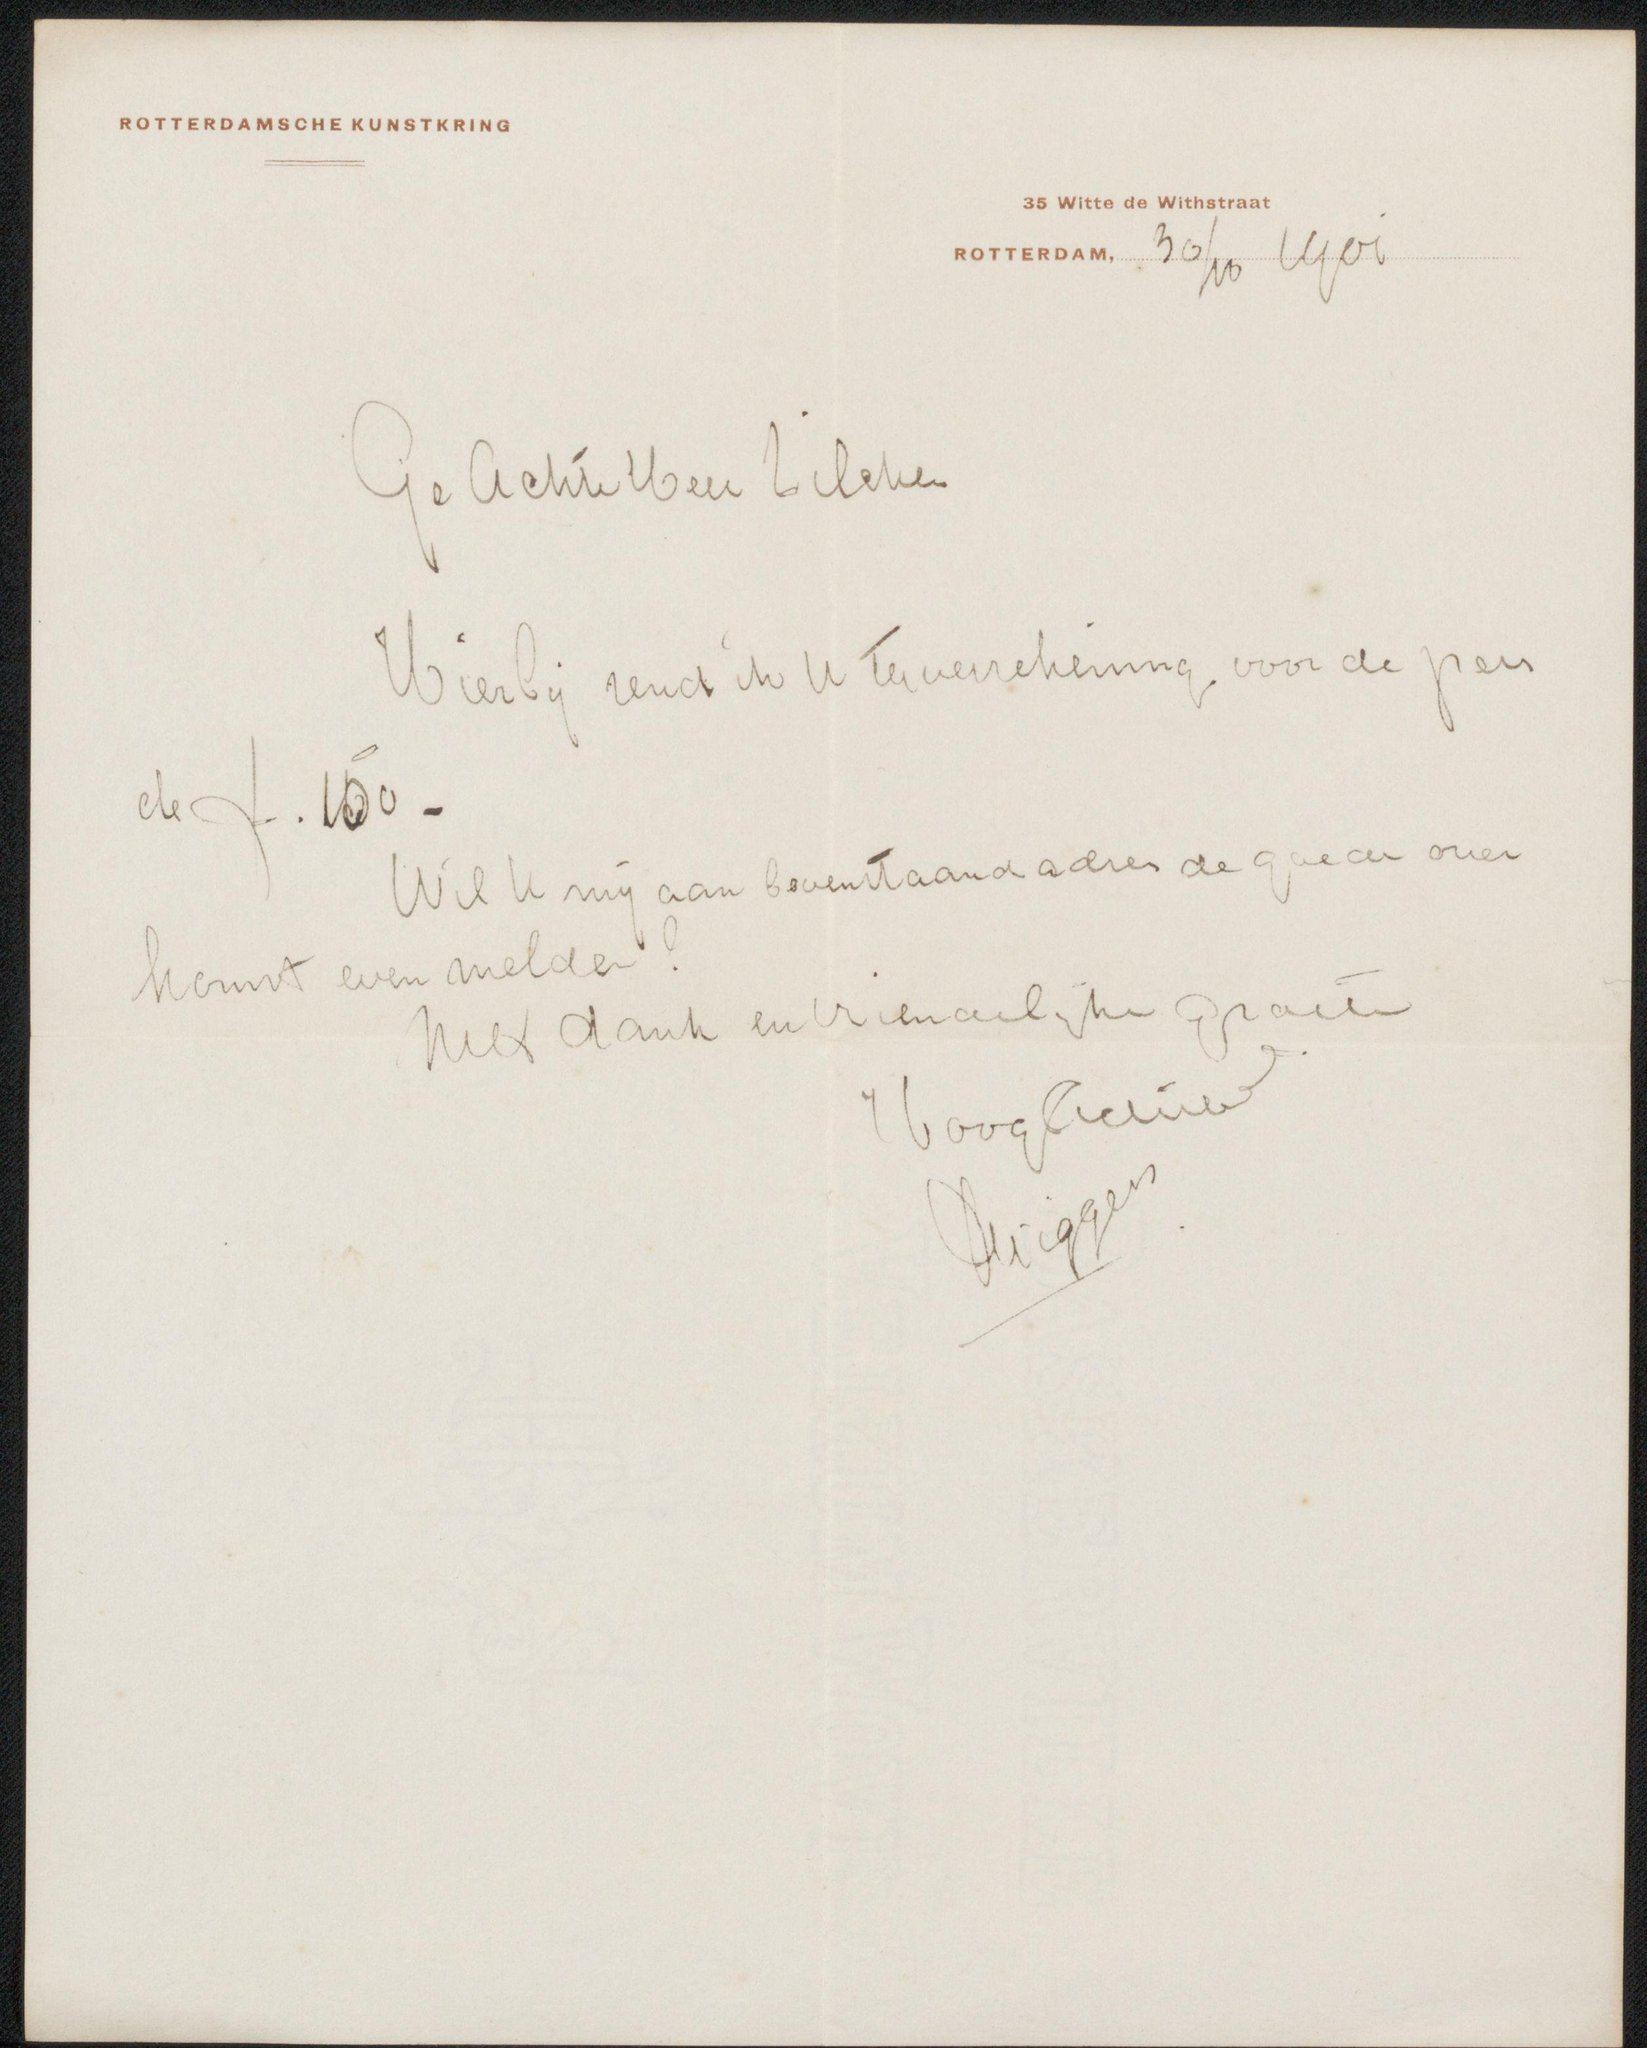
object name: letter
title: Brief aan Philip Zilcken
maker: derk wiggers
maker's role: draughtsman, painter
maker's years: 1866-1933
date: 1901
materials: ink, paper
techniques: pen, printing, writing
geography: rotterdam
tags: the hague, painter, draughtsman, philip zilcken, the graphic arts, money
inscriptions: watermark, collector's mark: ‘RPK’